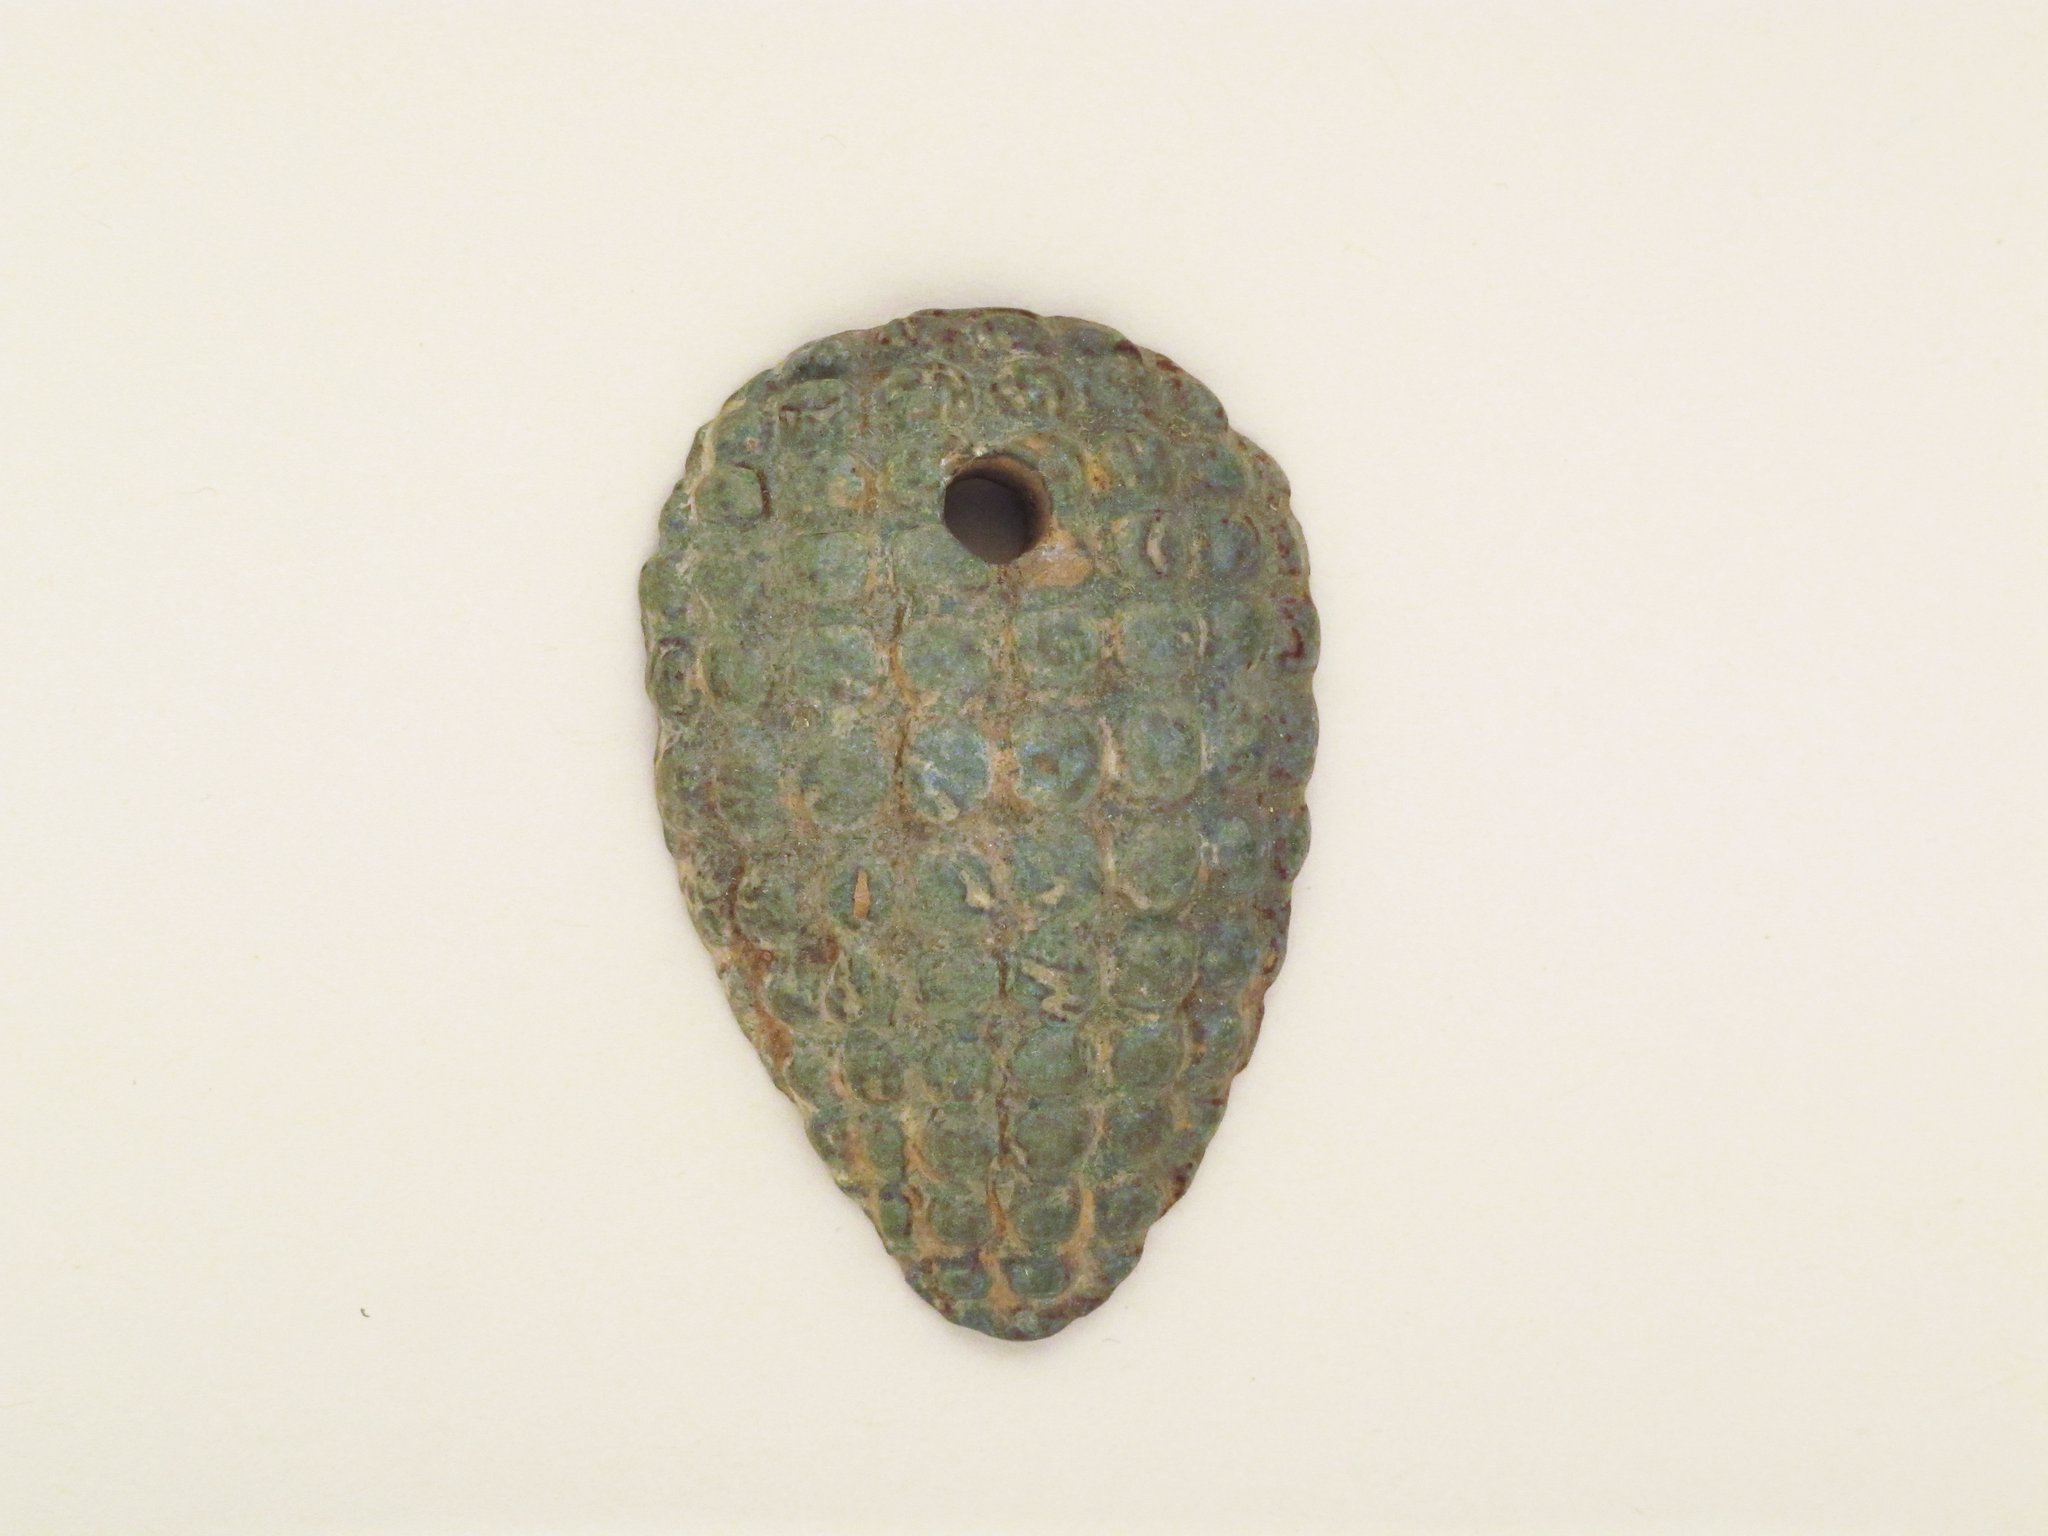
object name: amulet, grape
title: Faience pendant in the form of grapes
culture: egyptian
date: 1300-1101 BCE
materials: faience